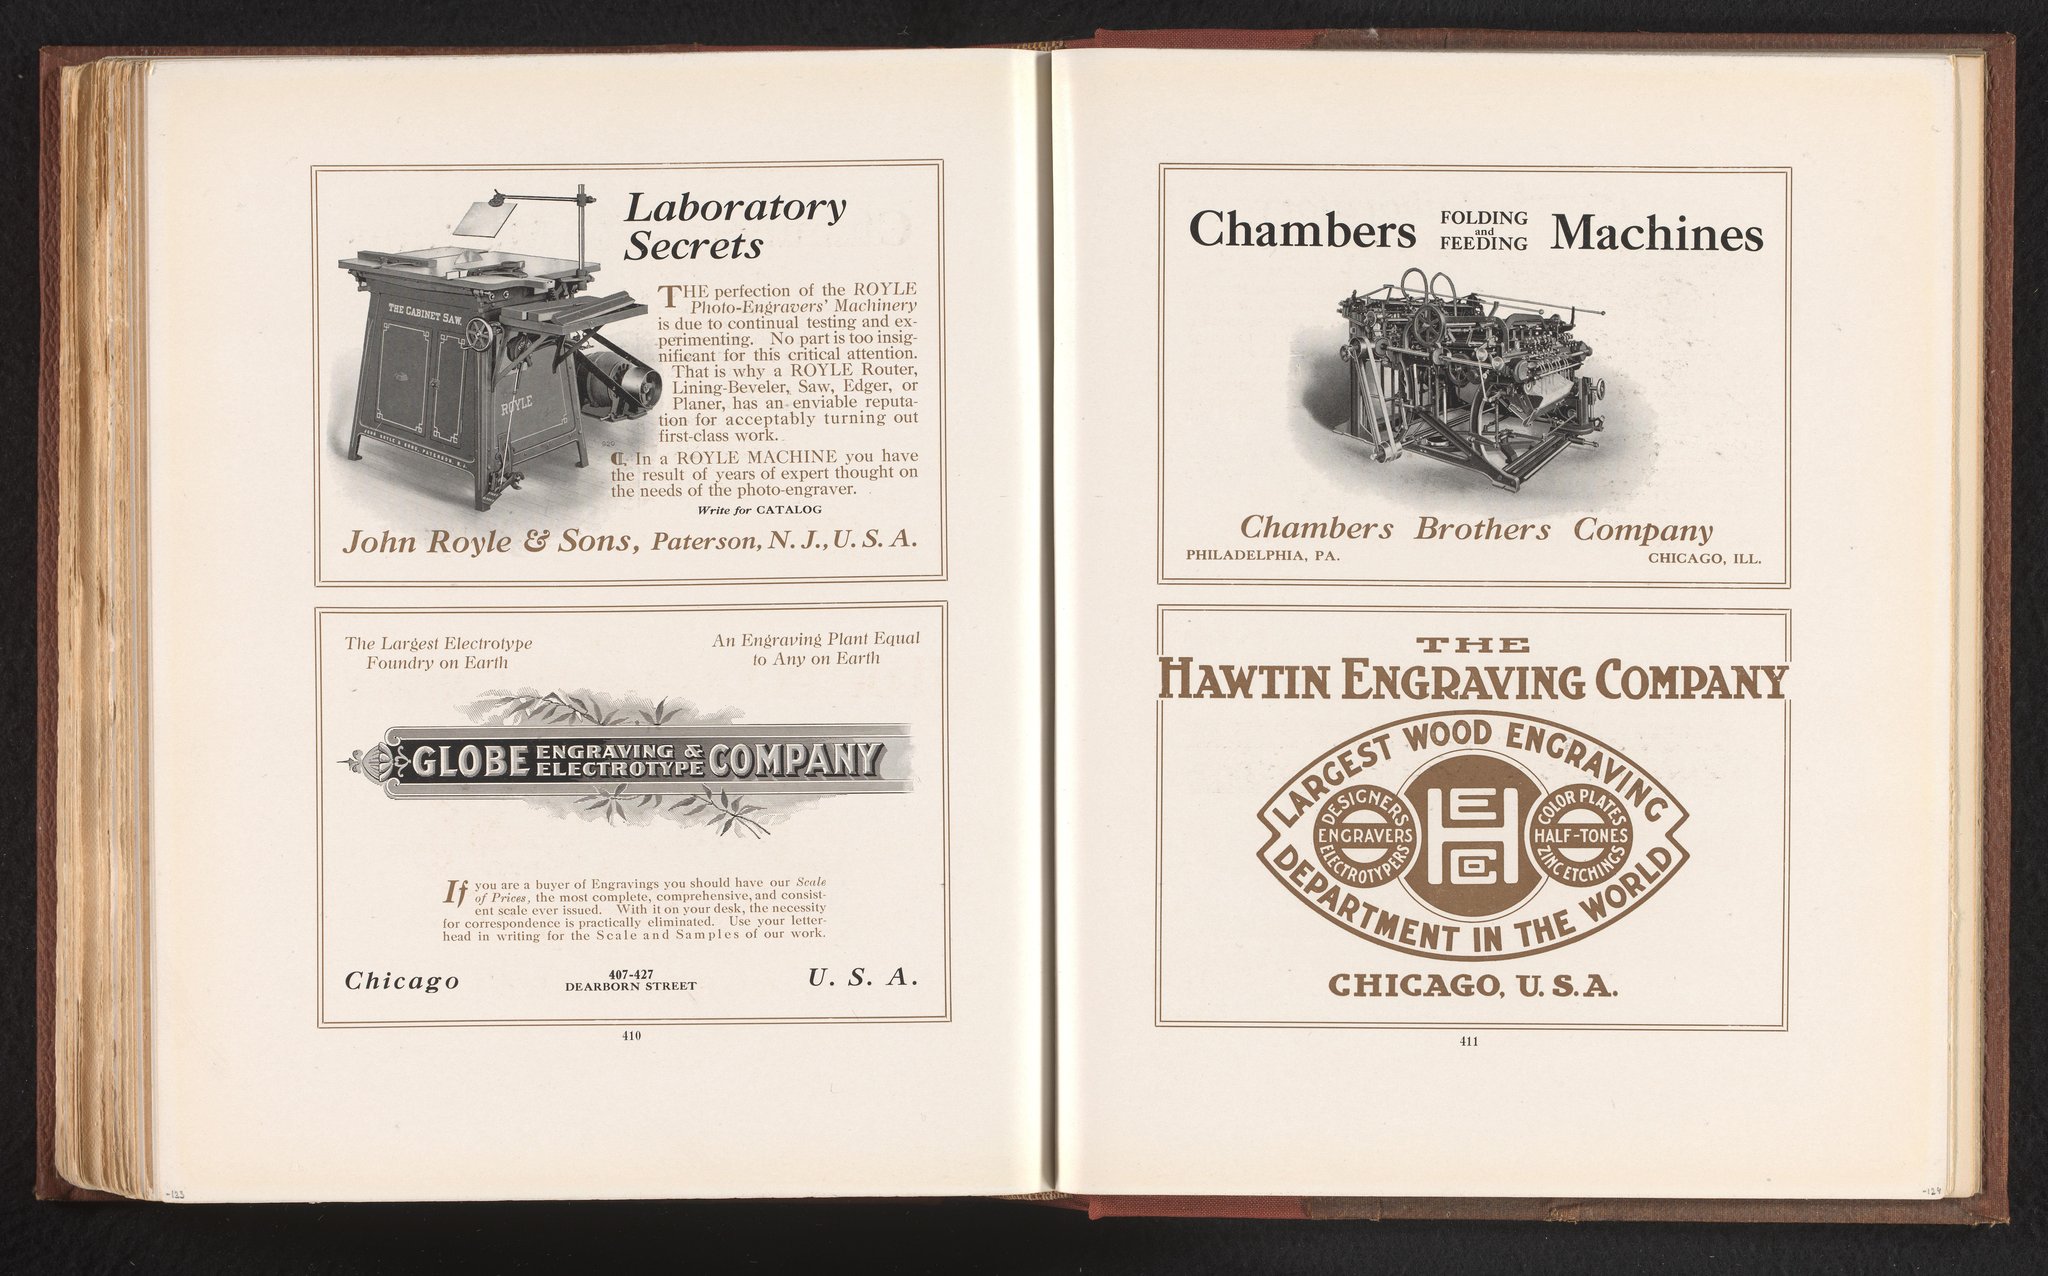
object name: photomechanical print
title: Reclames, waaronder voor Chambers Brothers Company geïllustreerd met één van hun 'Folding and Feeding Machines'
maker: Anonymous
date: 1904-1909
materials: paper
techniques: autotype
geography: chicago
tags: advertising, machines, engines ~ crafts and industries